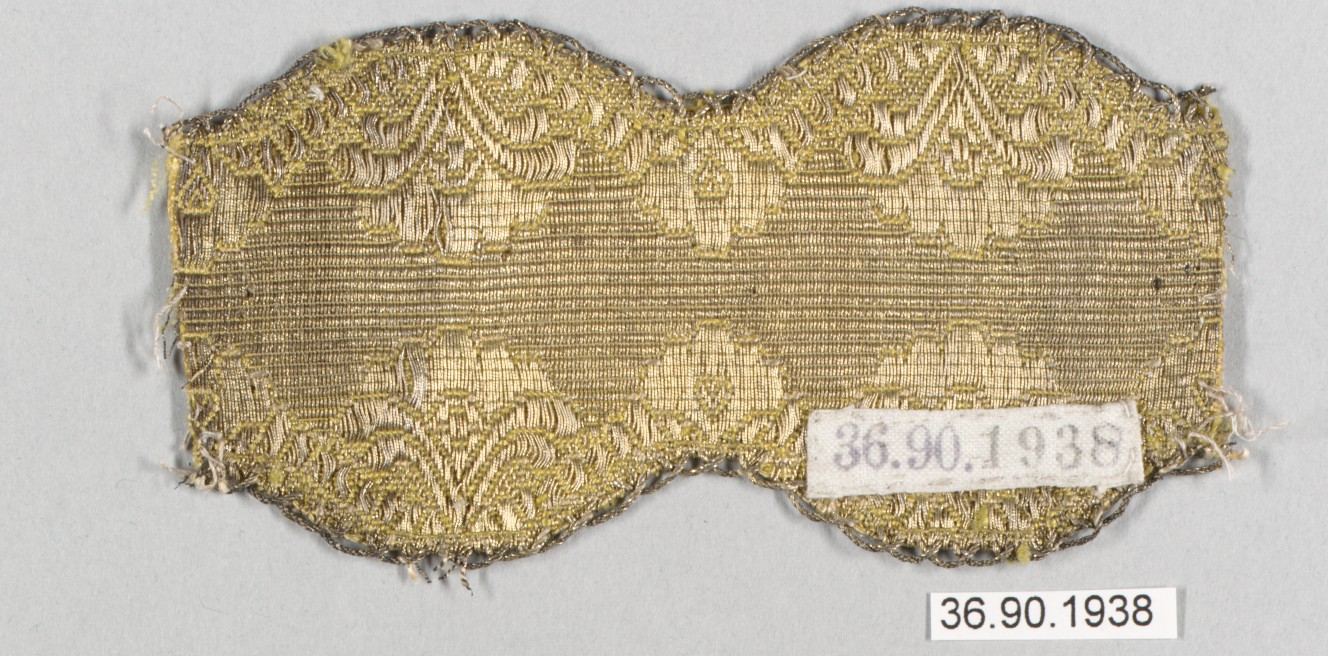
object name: galloon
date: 1767-1833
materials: metal thread